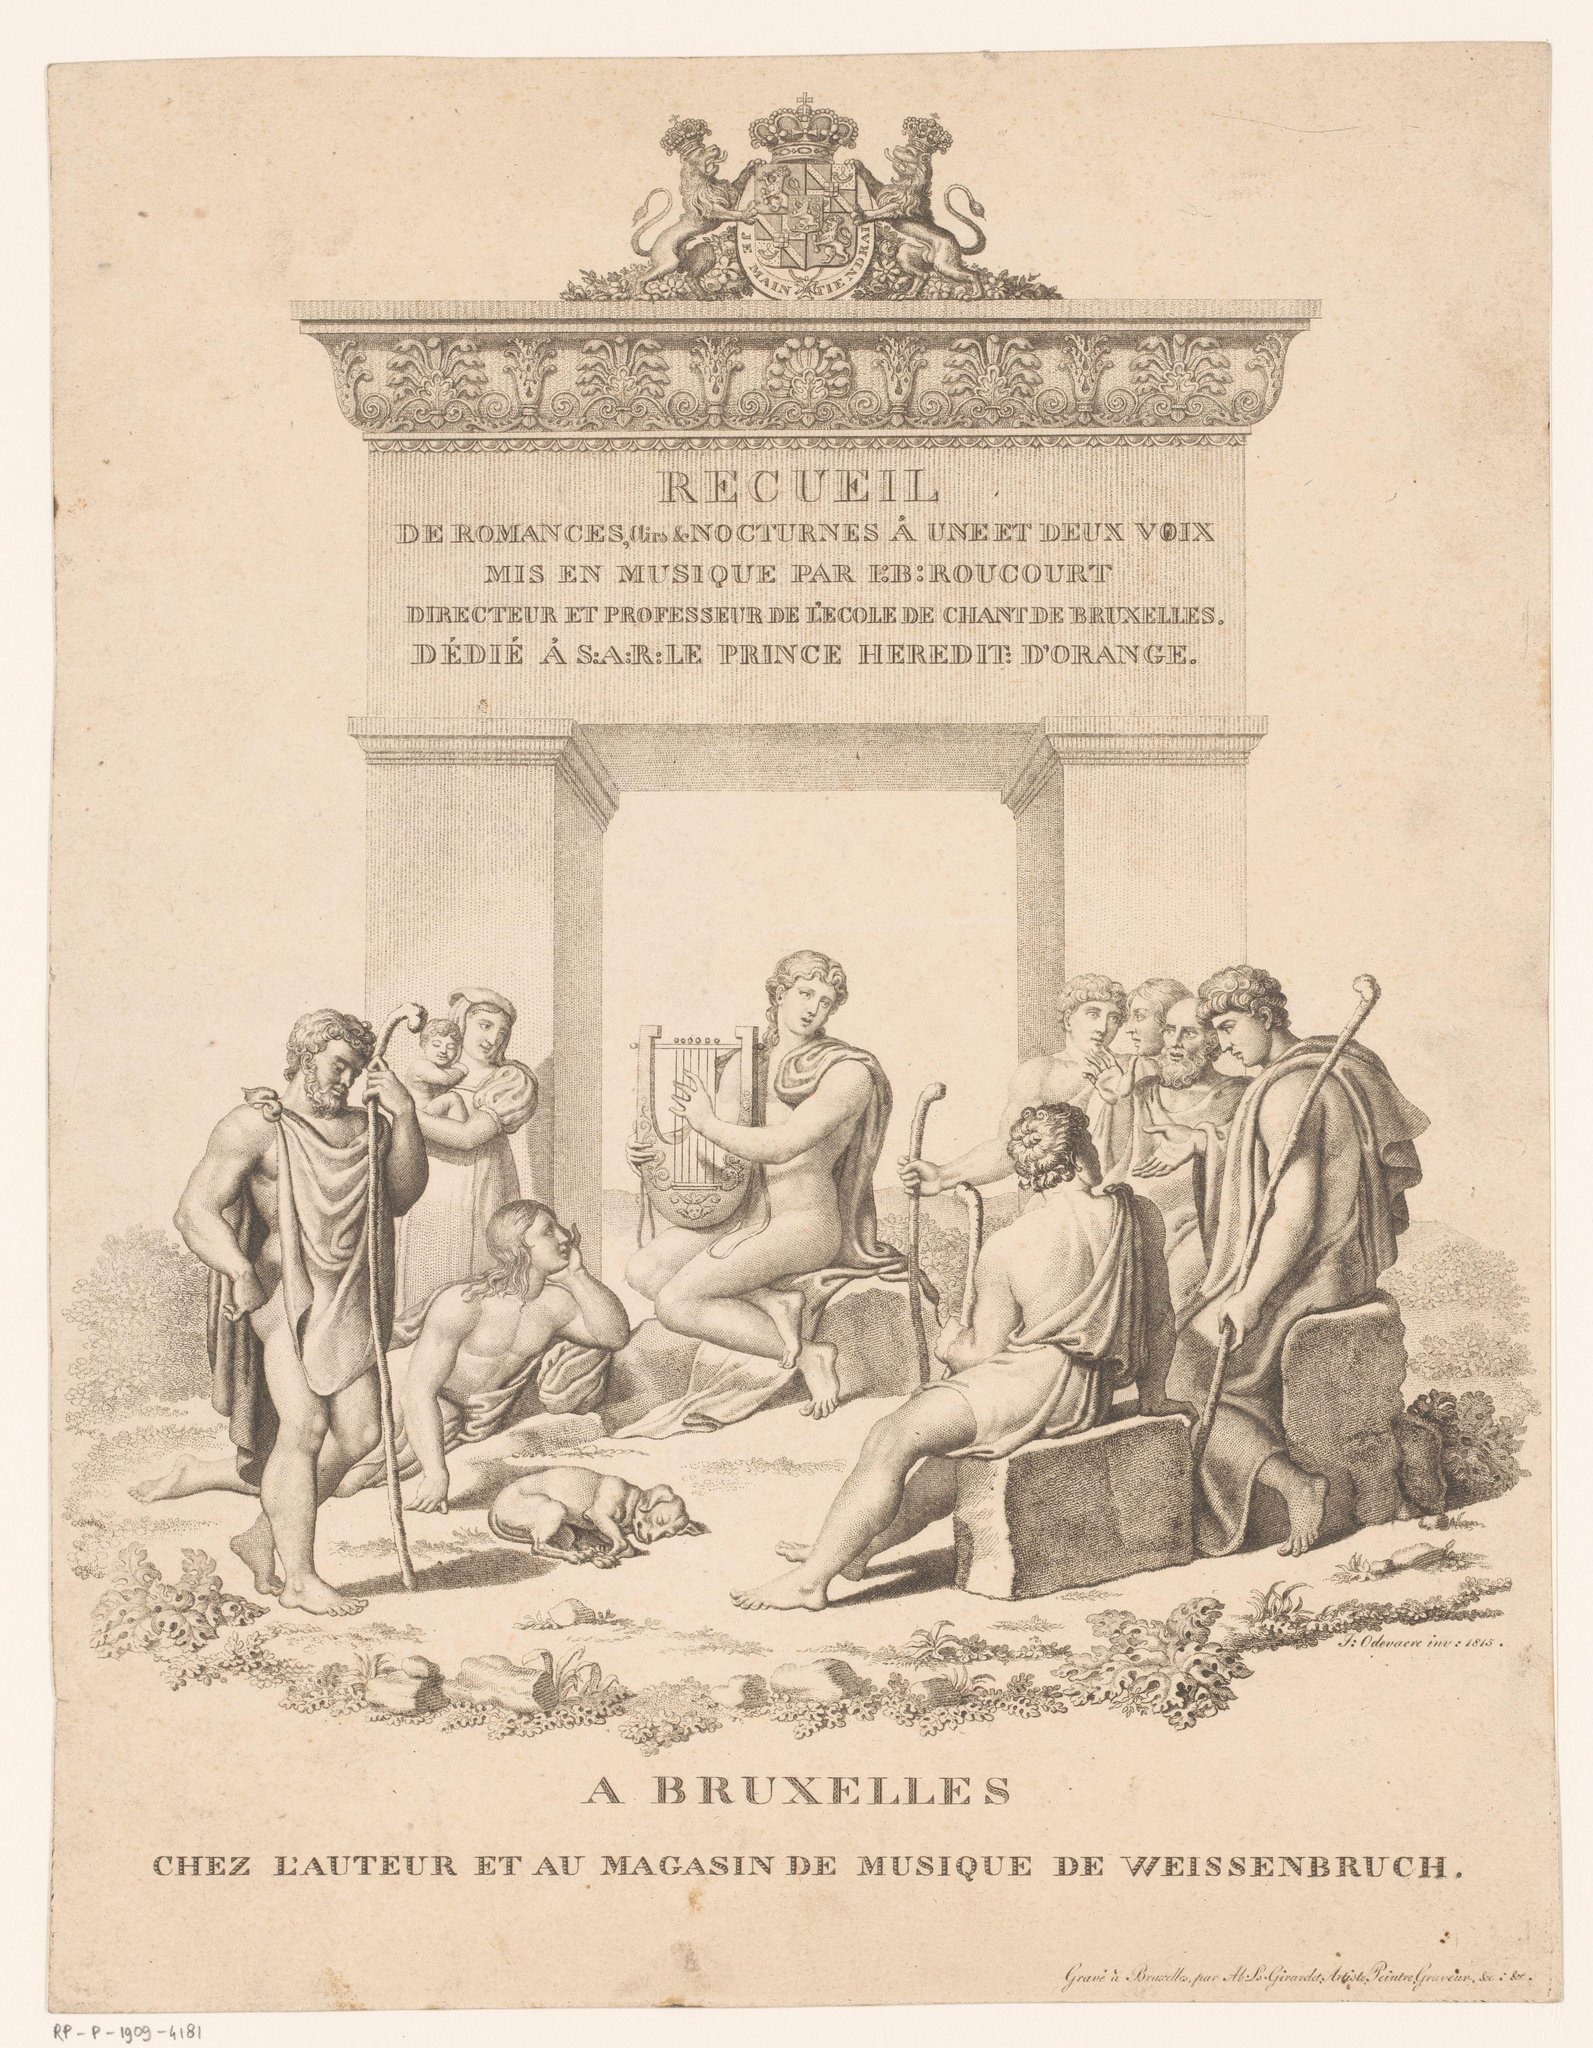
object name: print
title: Musicerende Apollo te midden van herders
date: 1815-1820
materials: paper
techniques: engraving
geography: brussels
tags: apollo playing the lyre, apollo citharoedus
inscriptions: collector's mark: Lugt 2228